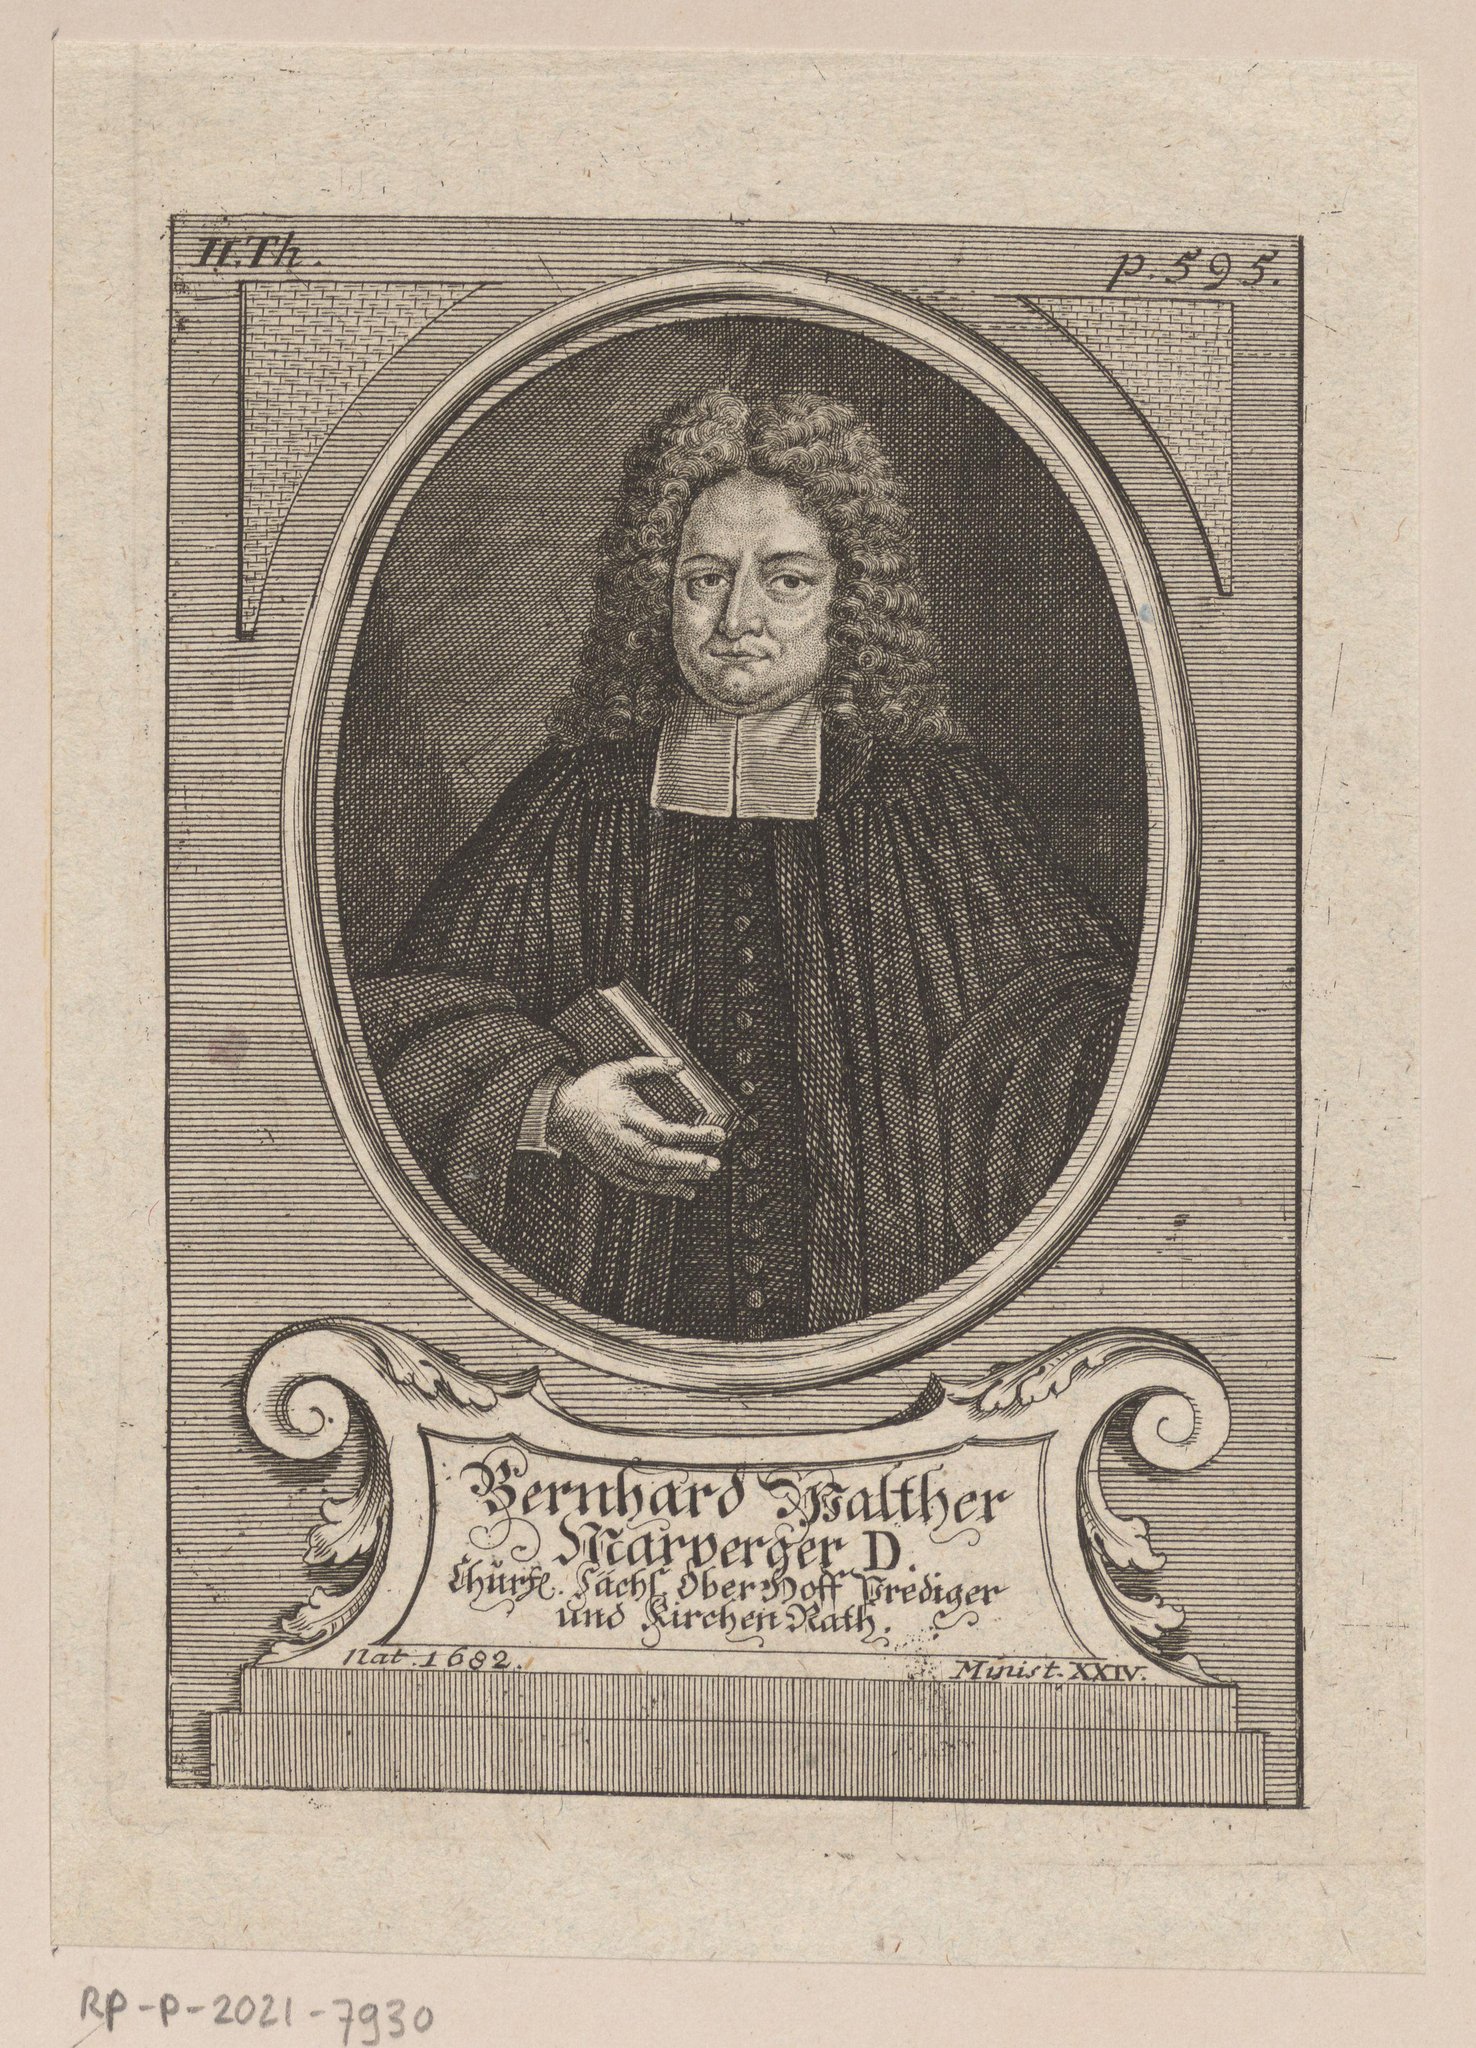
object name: book illustration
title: Portret van Bernhard Walther Marperger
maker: Anonymous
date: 1724-1746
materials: paper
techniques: engraving, etching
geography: germany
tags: theologian, ornament ~ medallion, historical persons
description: Met onderschrift in het Duits. Linksboven: II. Th. Rechtsboven: p. 595.